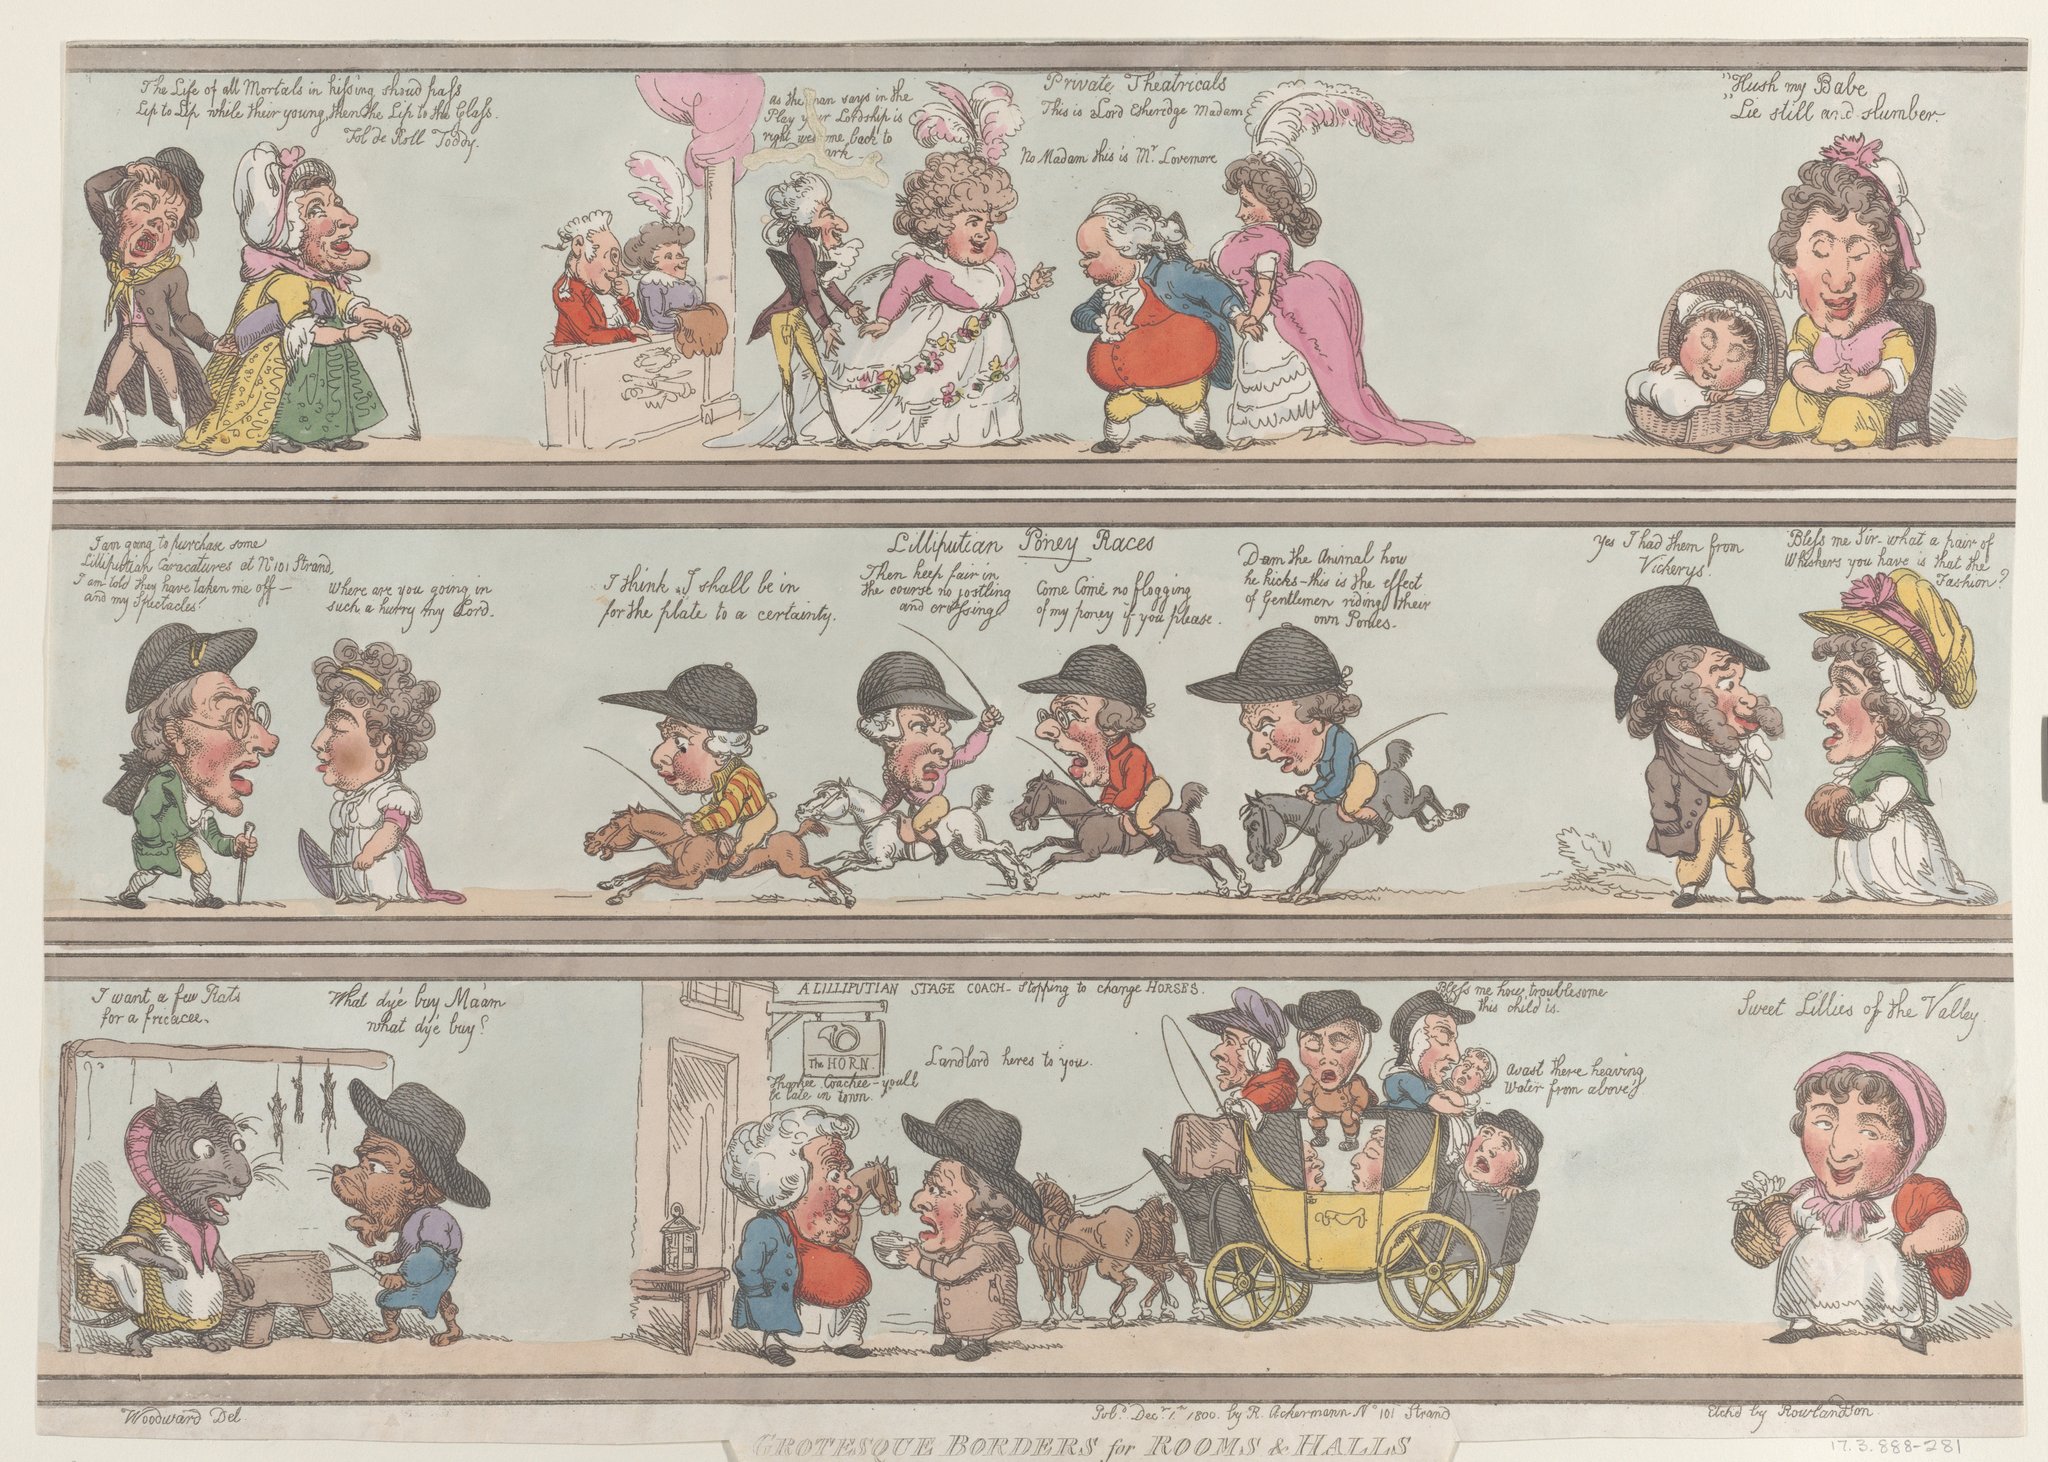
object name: print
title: Grotesque Borders for Rooms & Halls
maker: thomas rowlandson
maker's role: artist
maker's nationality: british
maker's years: 1757-1827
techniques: etching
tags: satire,men,women,horses,carriages